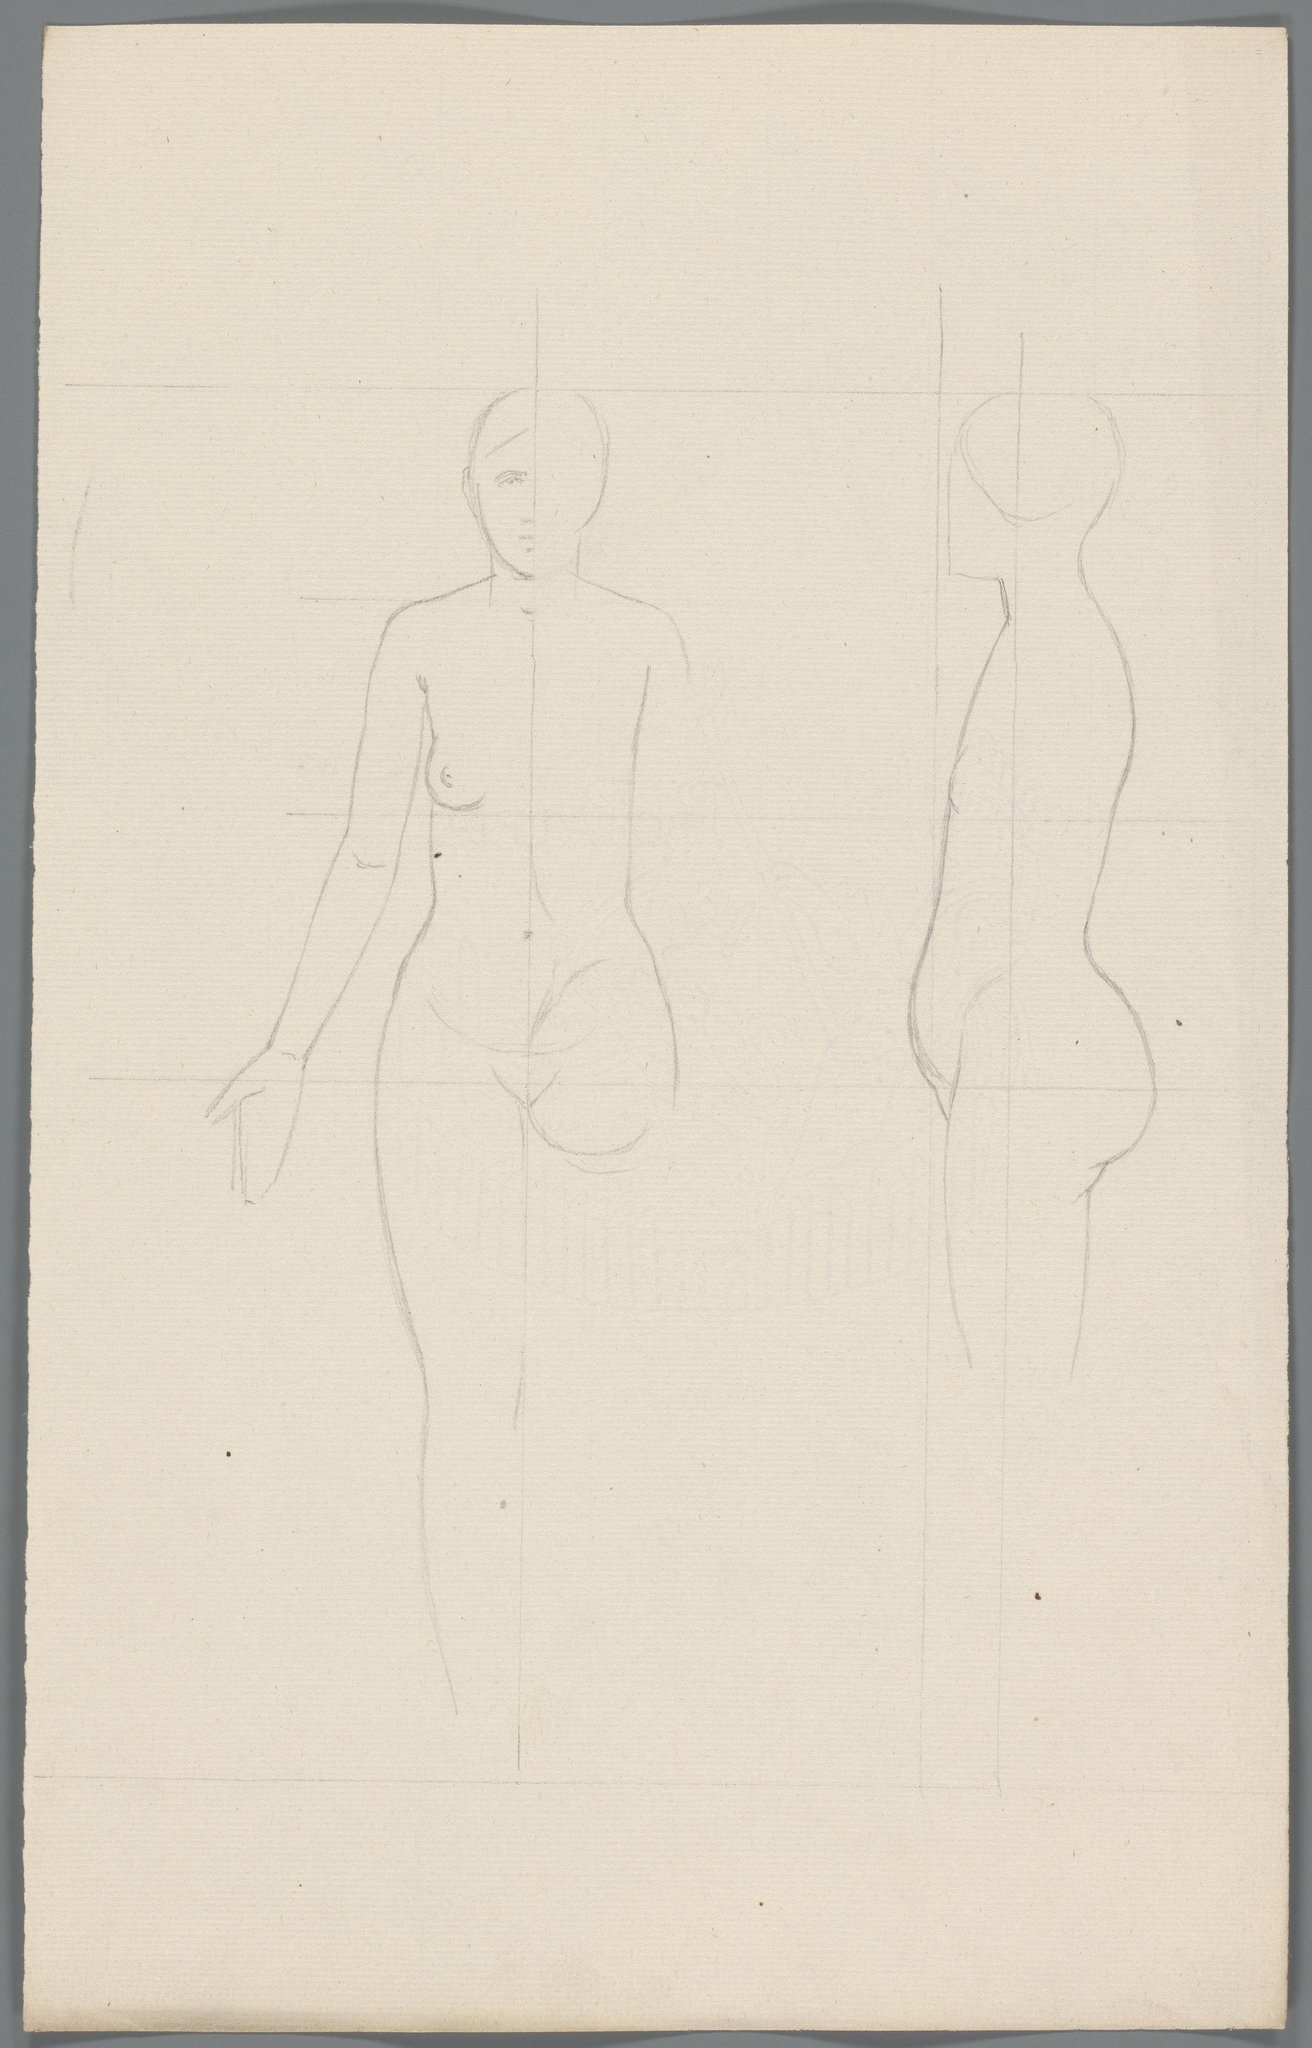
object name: drawing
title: Proportiestudie van een vrouw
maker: jacobus everhardus josephus van den berg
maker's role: draughtsman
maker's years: 1802-1861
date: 1812-1861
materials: paper, pencil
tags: standing figure (canon, proportions) - aa - female human figure, anatomy (non-medical) - aa - female human figure